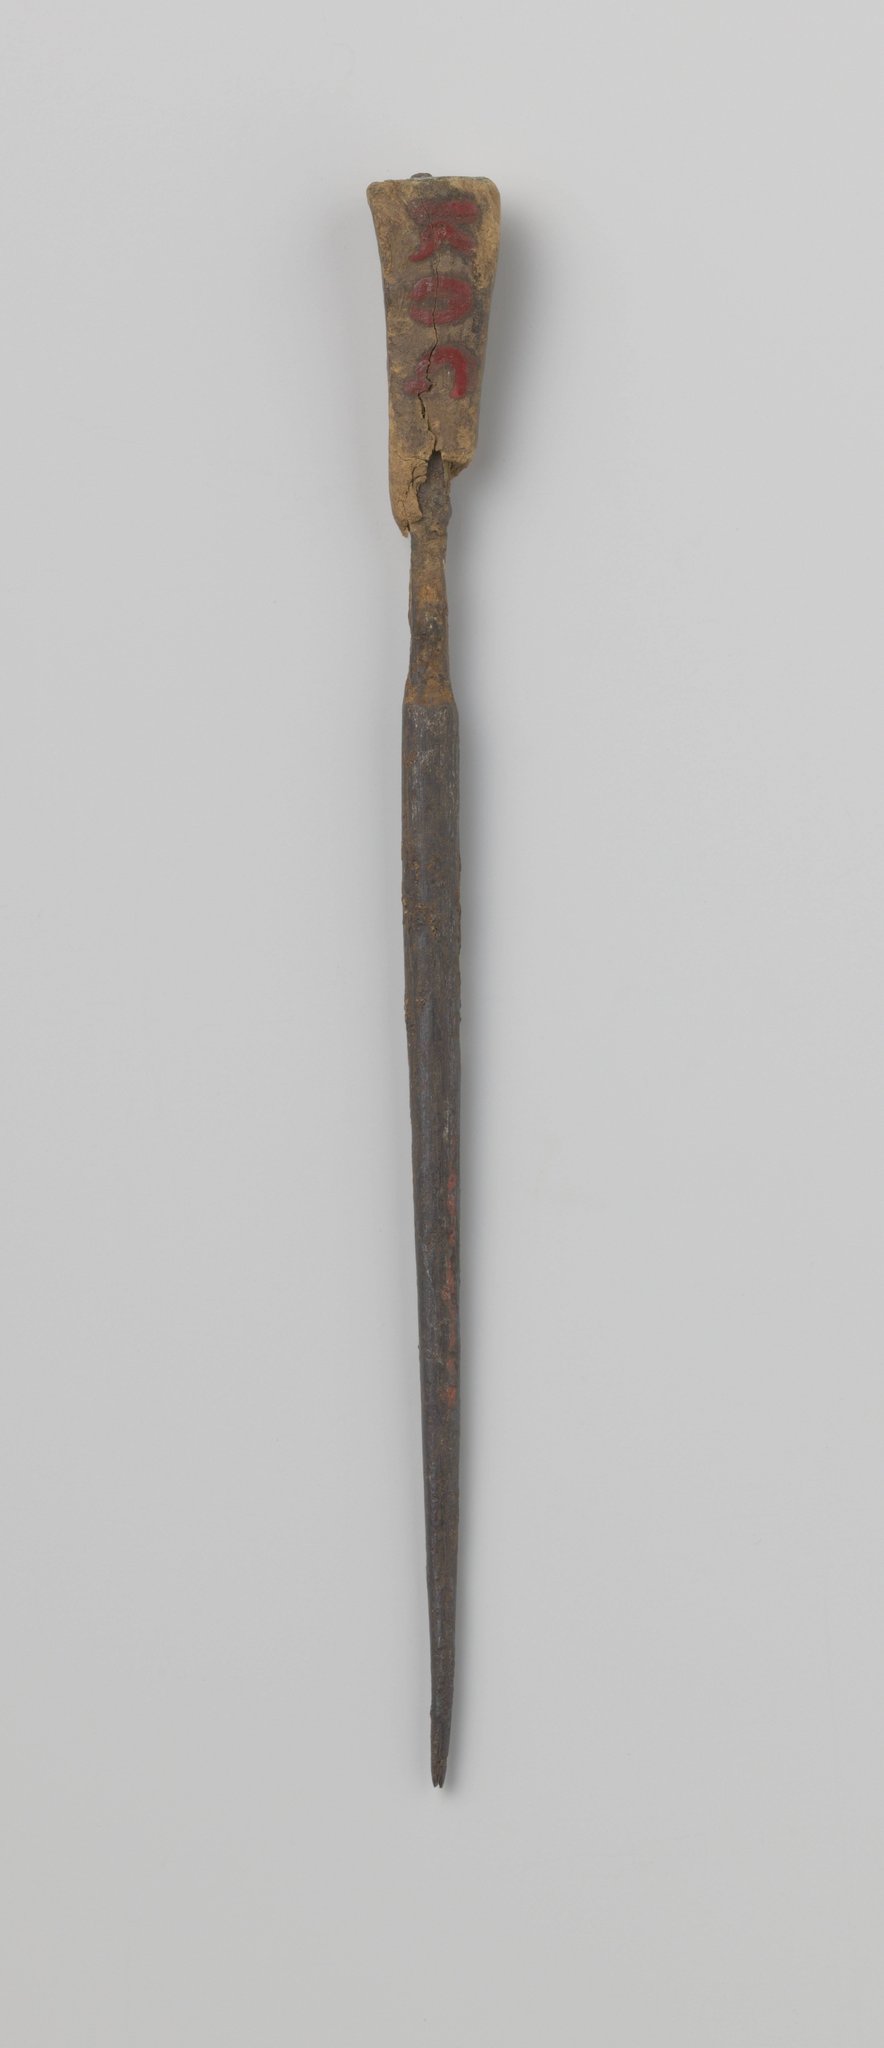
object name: dagger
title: Dolk of priem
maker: Anonymous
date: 1550-1849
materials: iron, wood